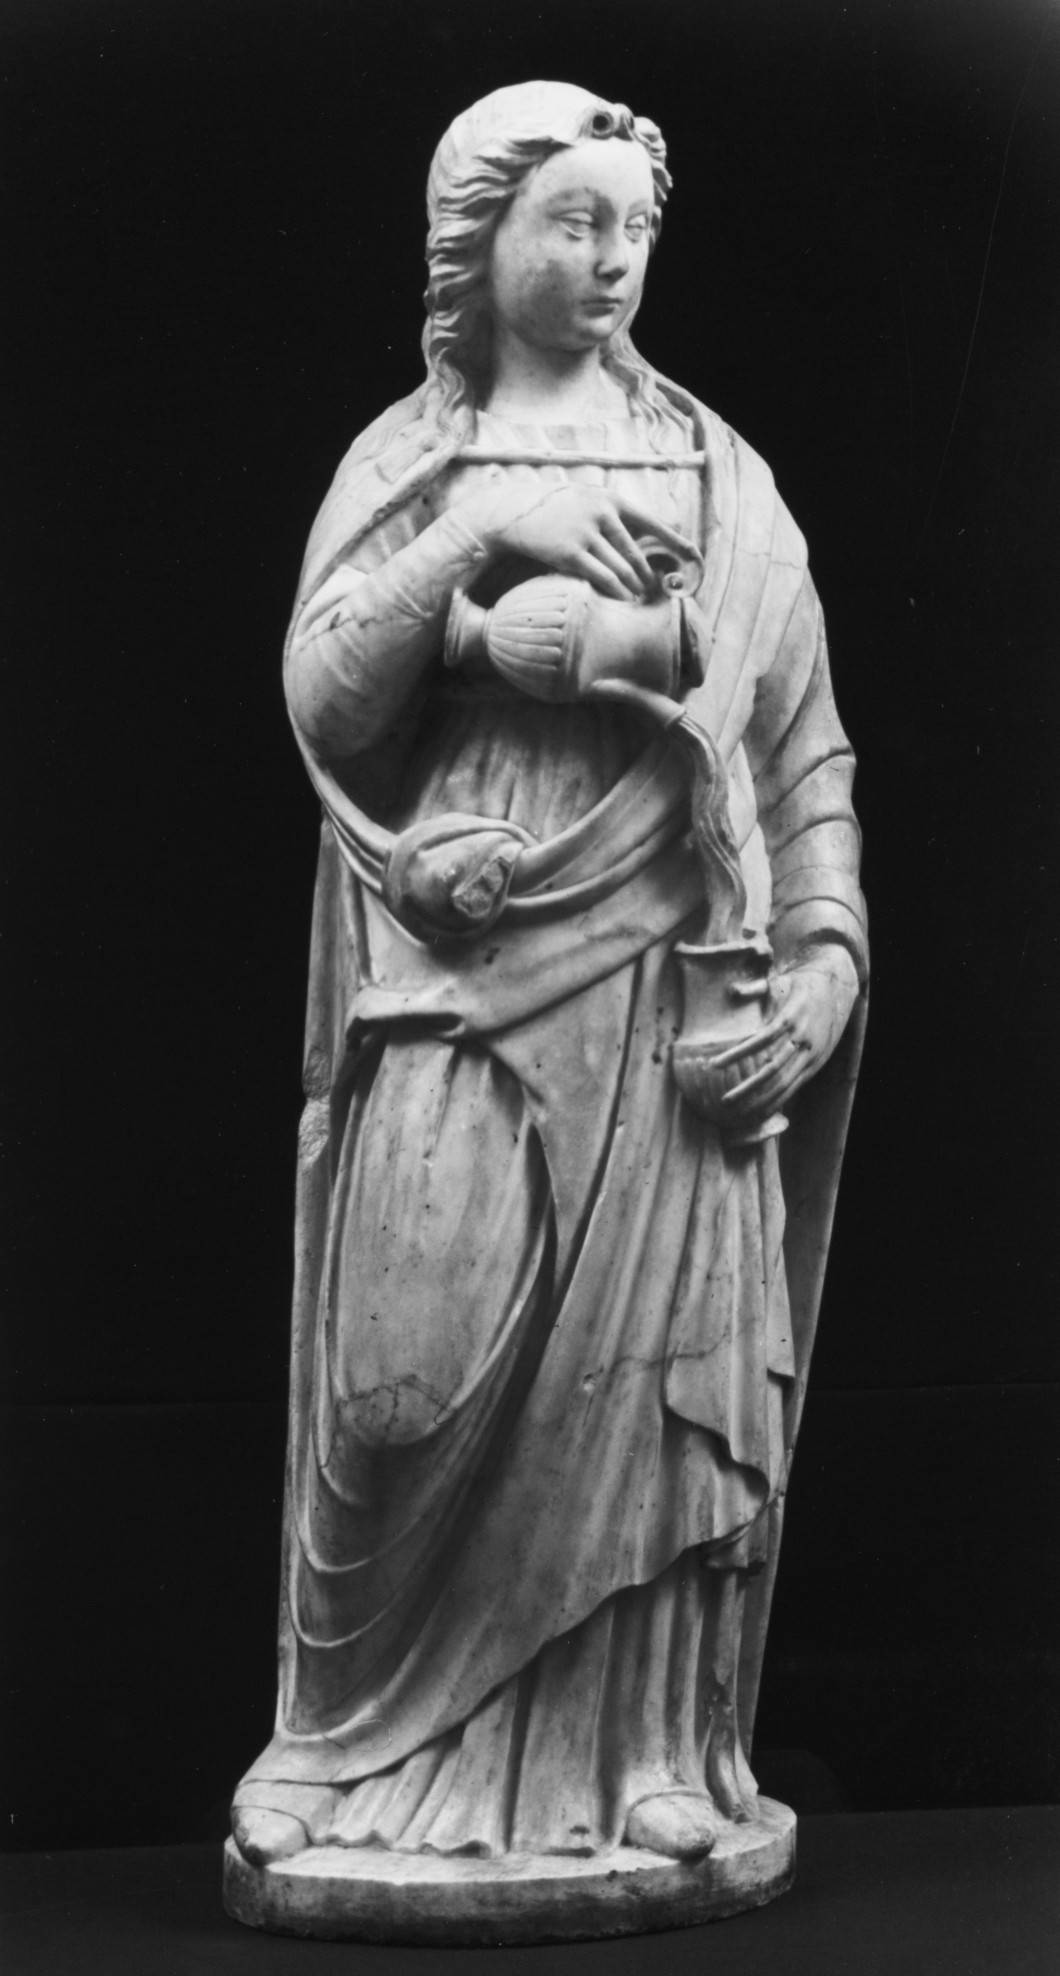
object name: statue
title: Temperance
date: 1451-1500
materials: marble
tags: women